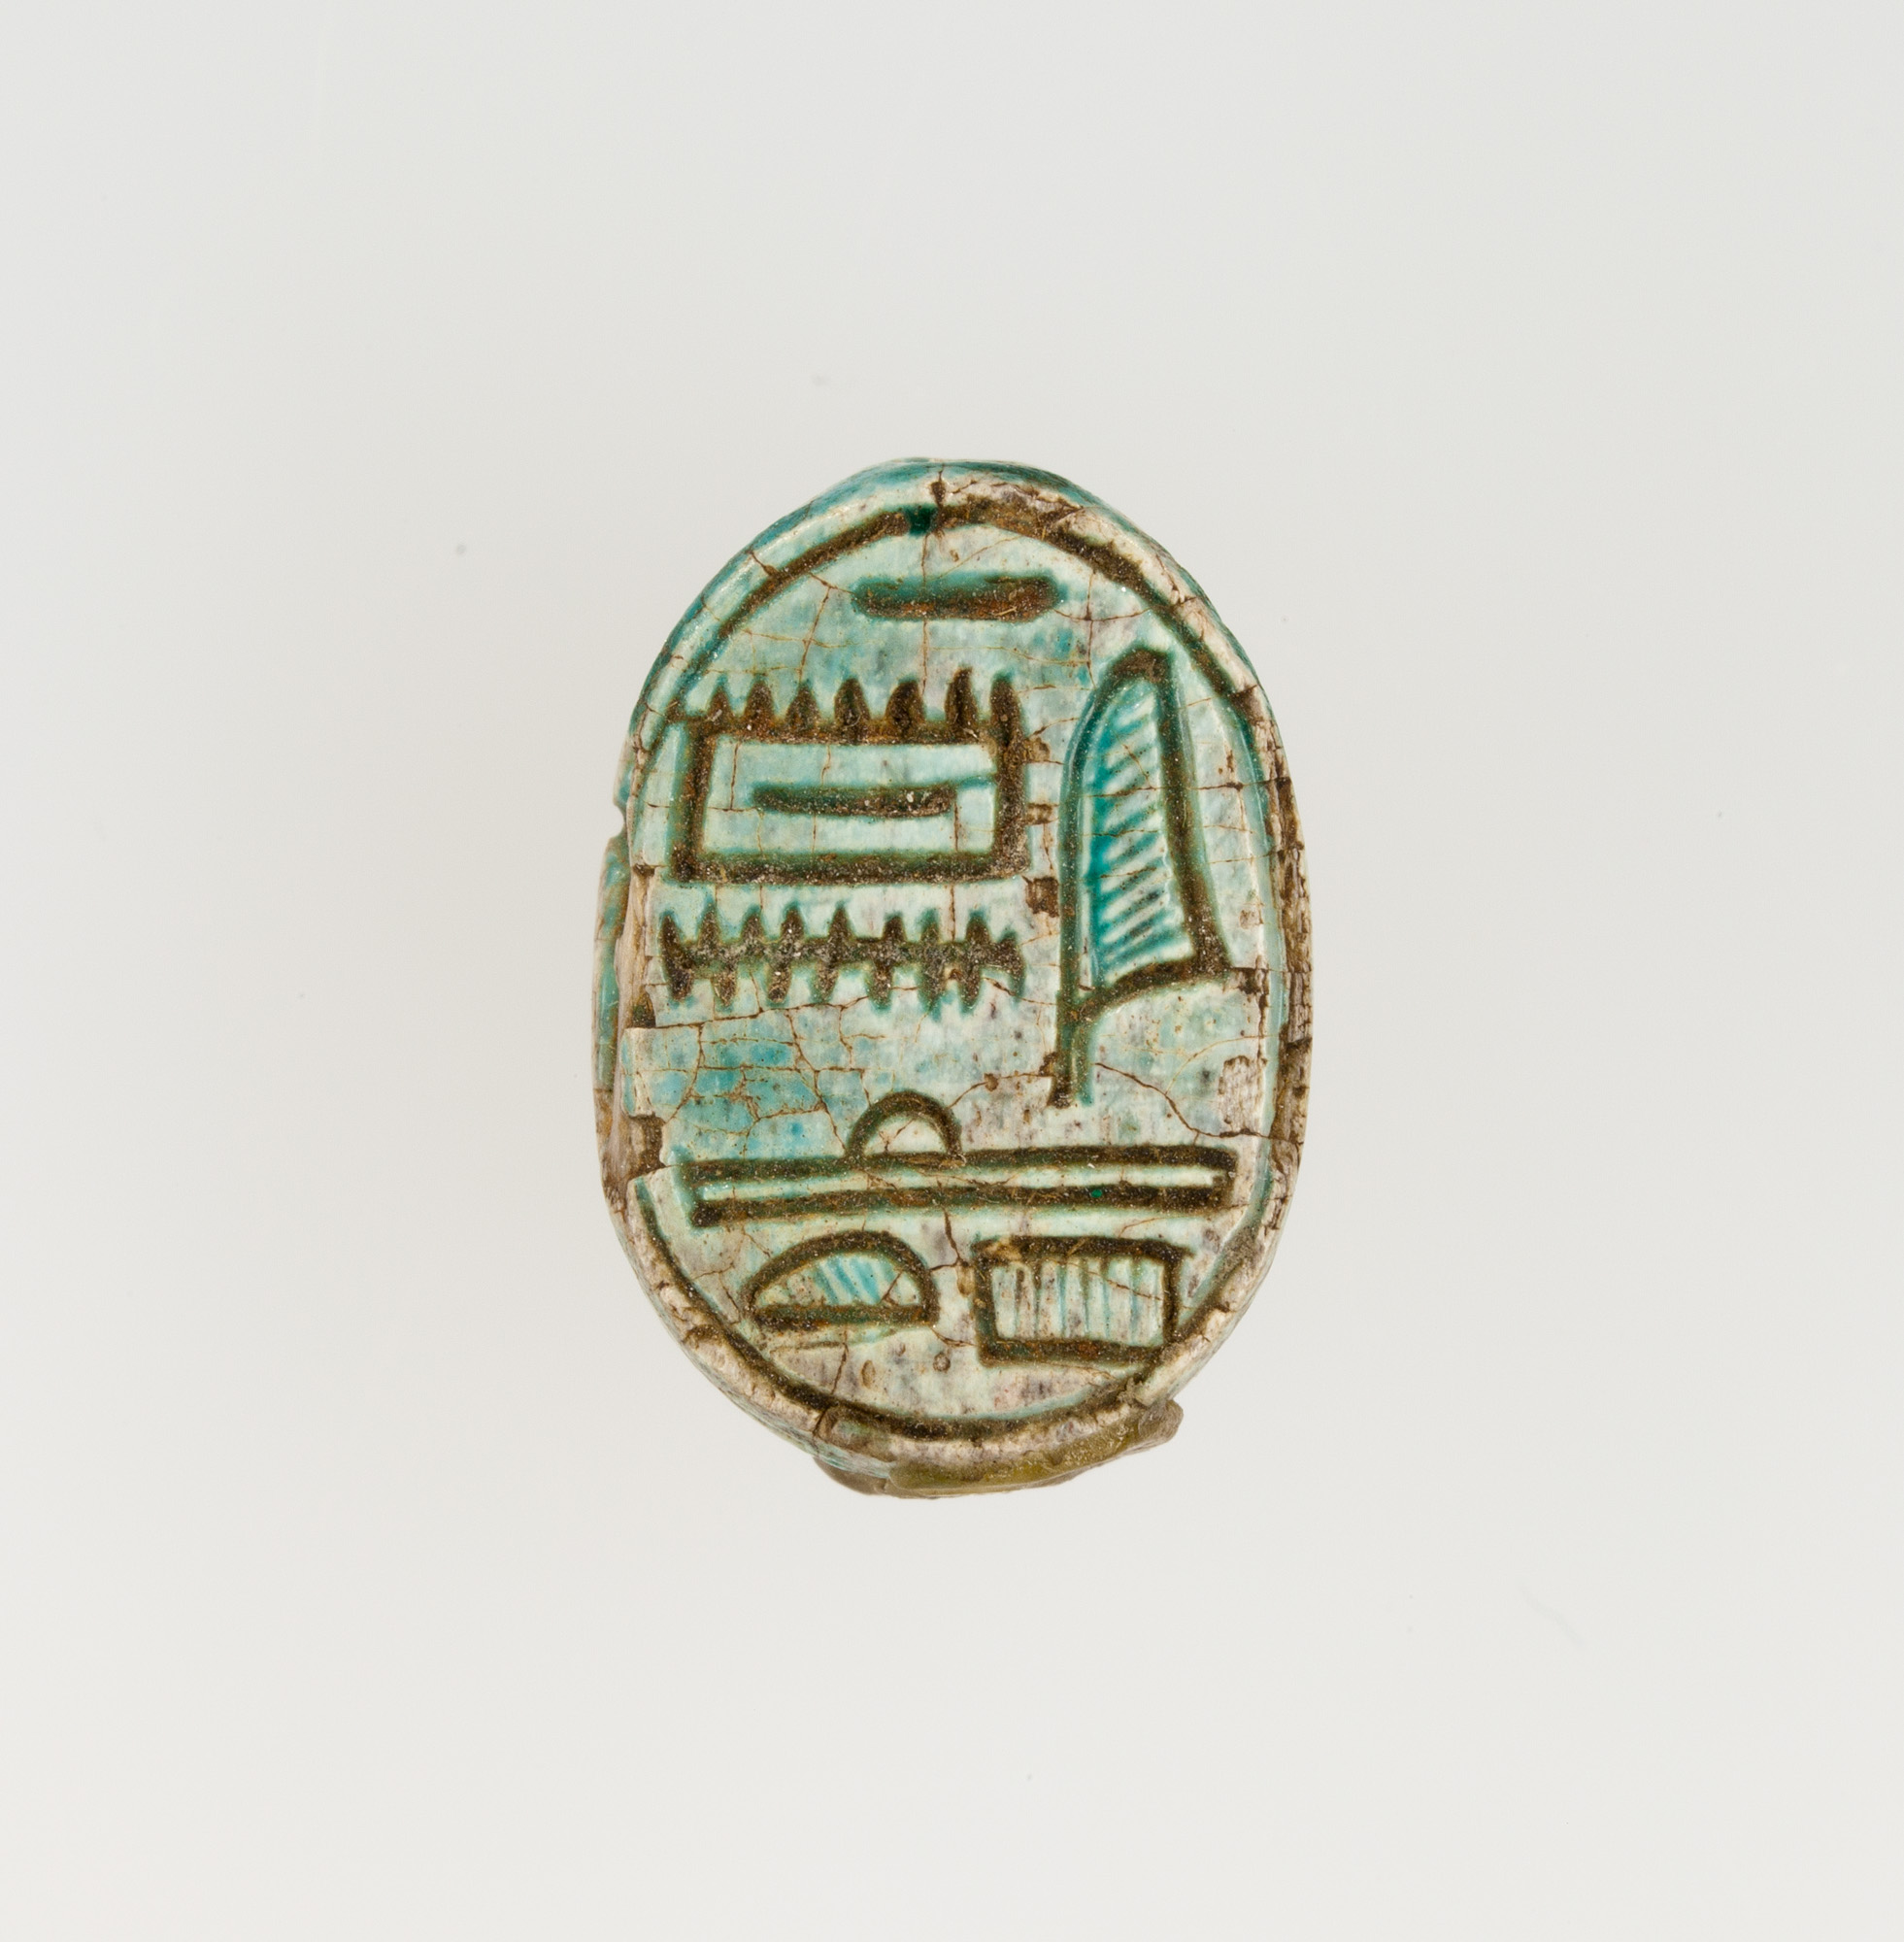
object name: scarab, amenhotep i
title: Scarab Inscribed with the Name Amenhotep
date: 1525-1504 BCE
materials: stone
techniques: glazing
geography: egypt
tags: hieroglyphs,scarabs